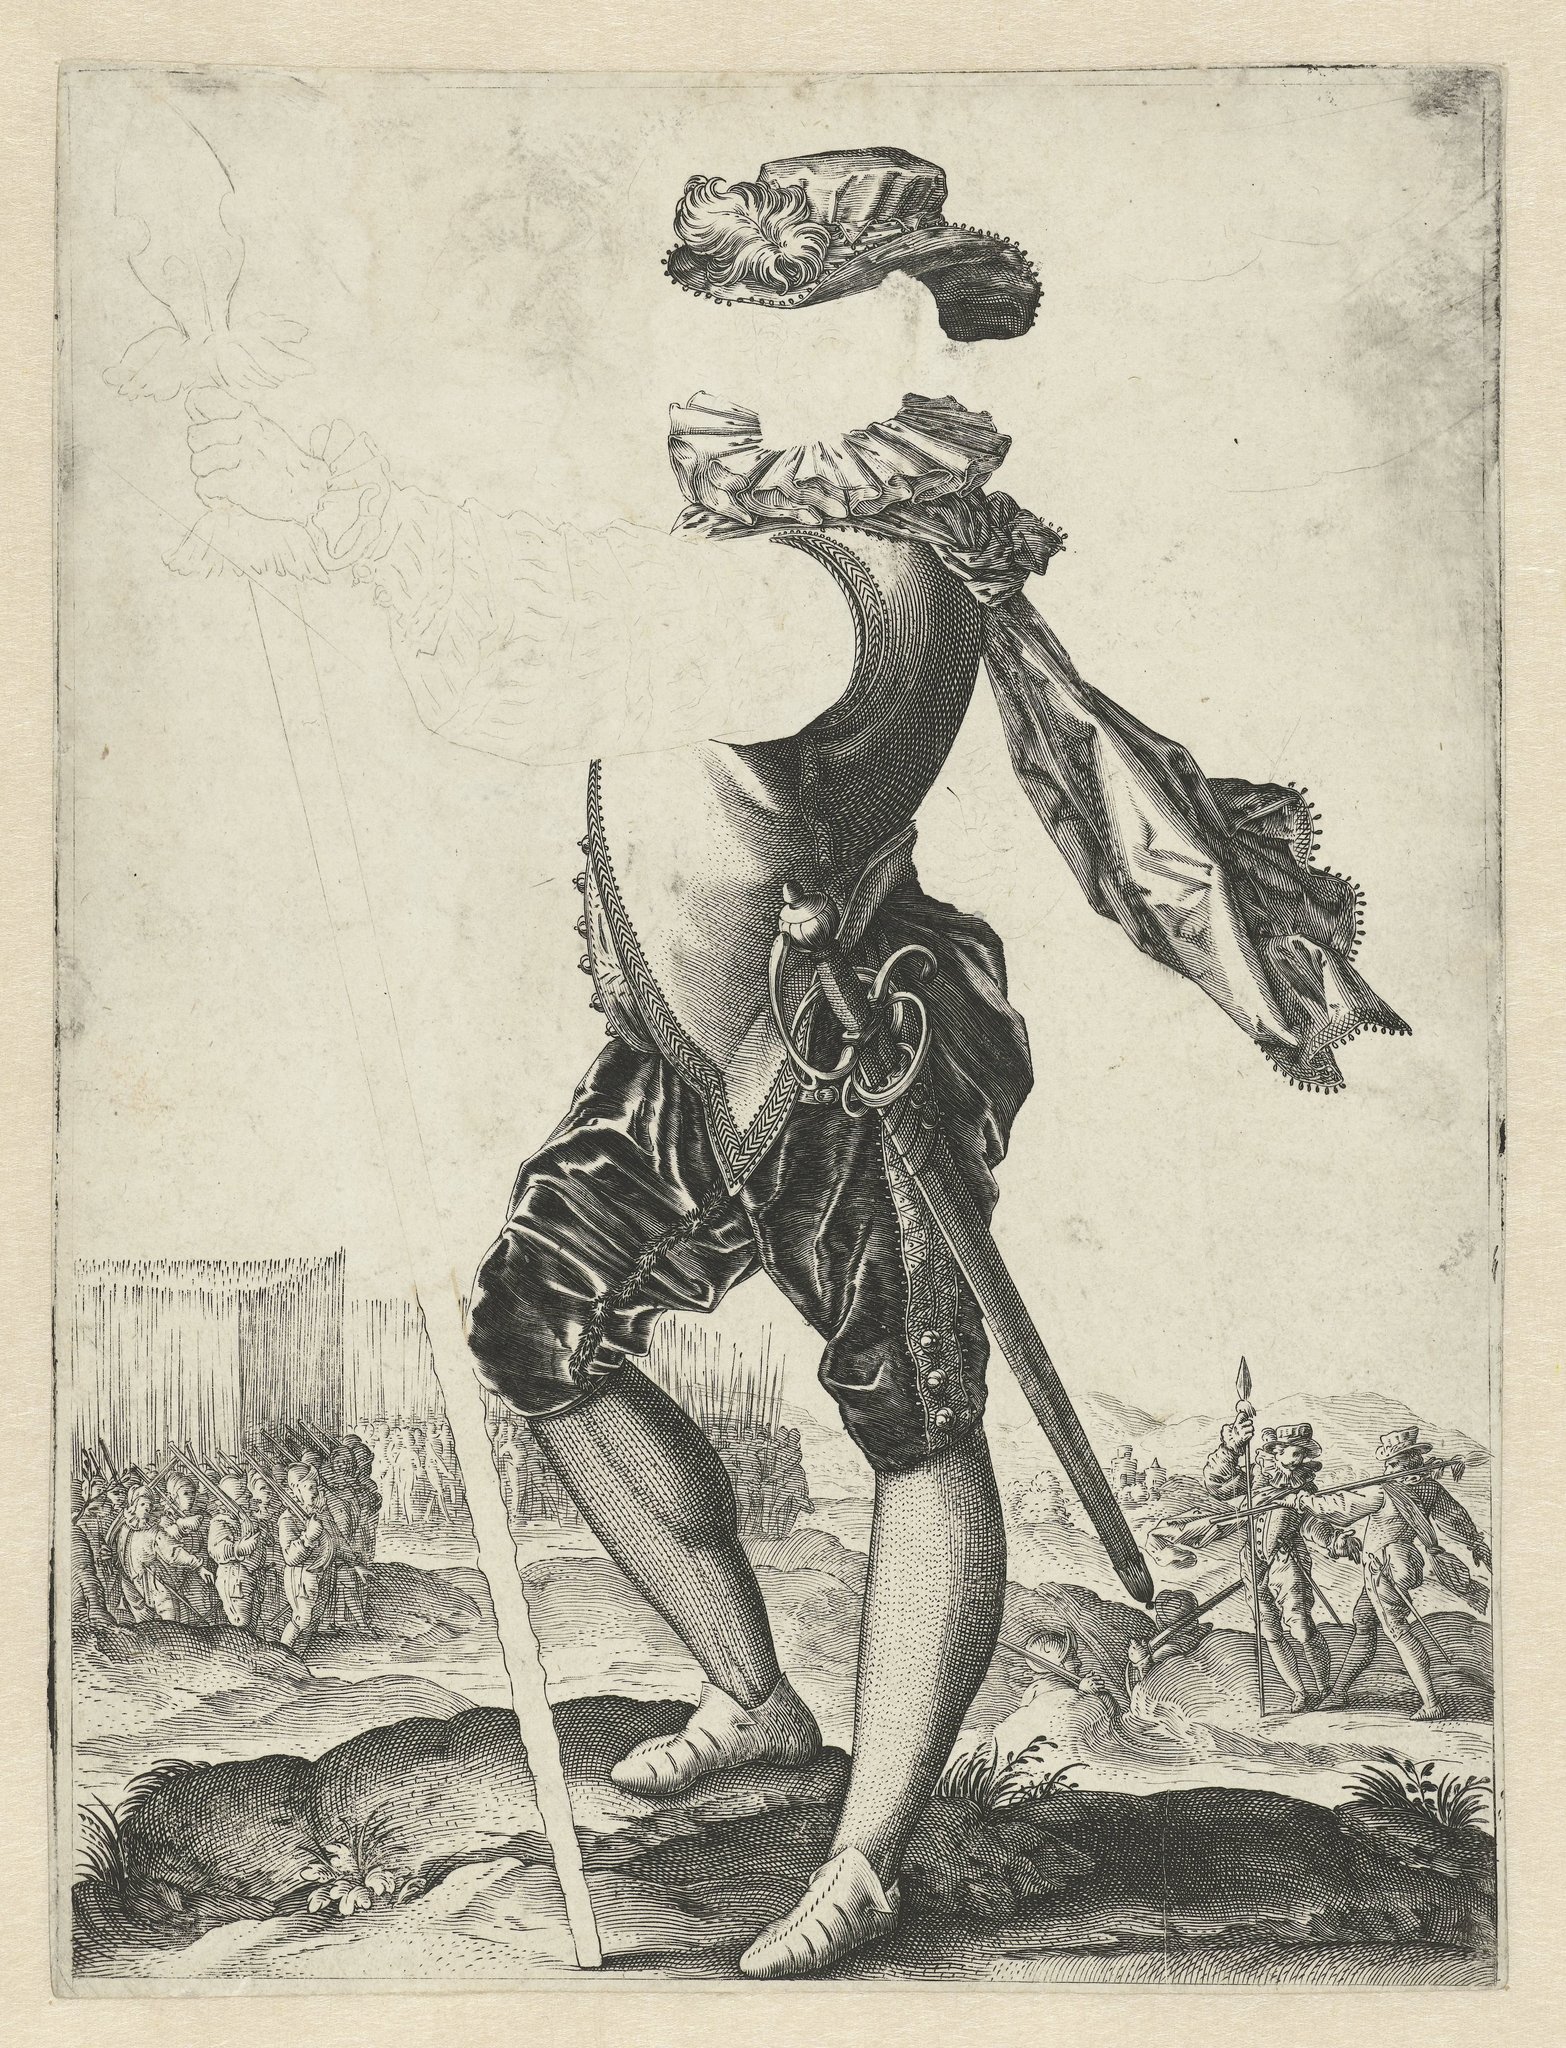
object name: print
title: Drie militaire functionarissen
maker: hendrick goltzius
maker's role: draughtsman, painter, print maker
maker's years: 1558-1617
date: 1585-1589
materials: paper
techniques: engraving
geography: haarlem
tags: officer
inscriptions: collector's mark: Lugt 2228a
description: Een man met een steekwapen (partizaan) in de rechterhand, ten voeten uit. Op de achtergrond infanterietroepen. Deze prent is een proefdruk: arm, hoofd en wapen zijn slechts met contourlijnen aangeduid en de achtergrond is nog niet volledig ingevuld. Deze prent is onderdeel van een serie van drie militaire functionarissen.